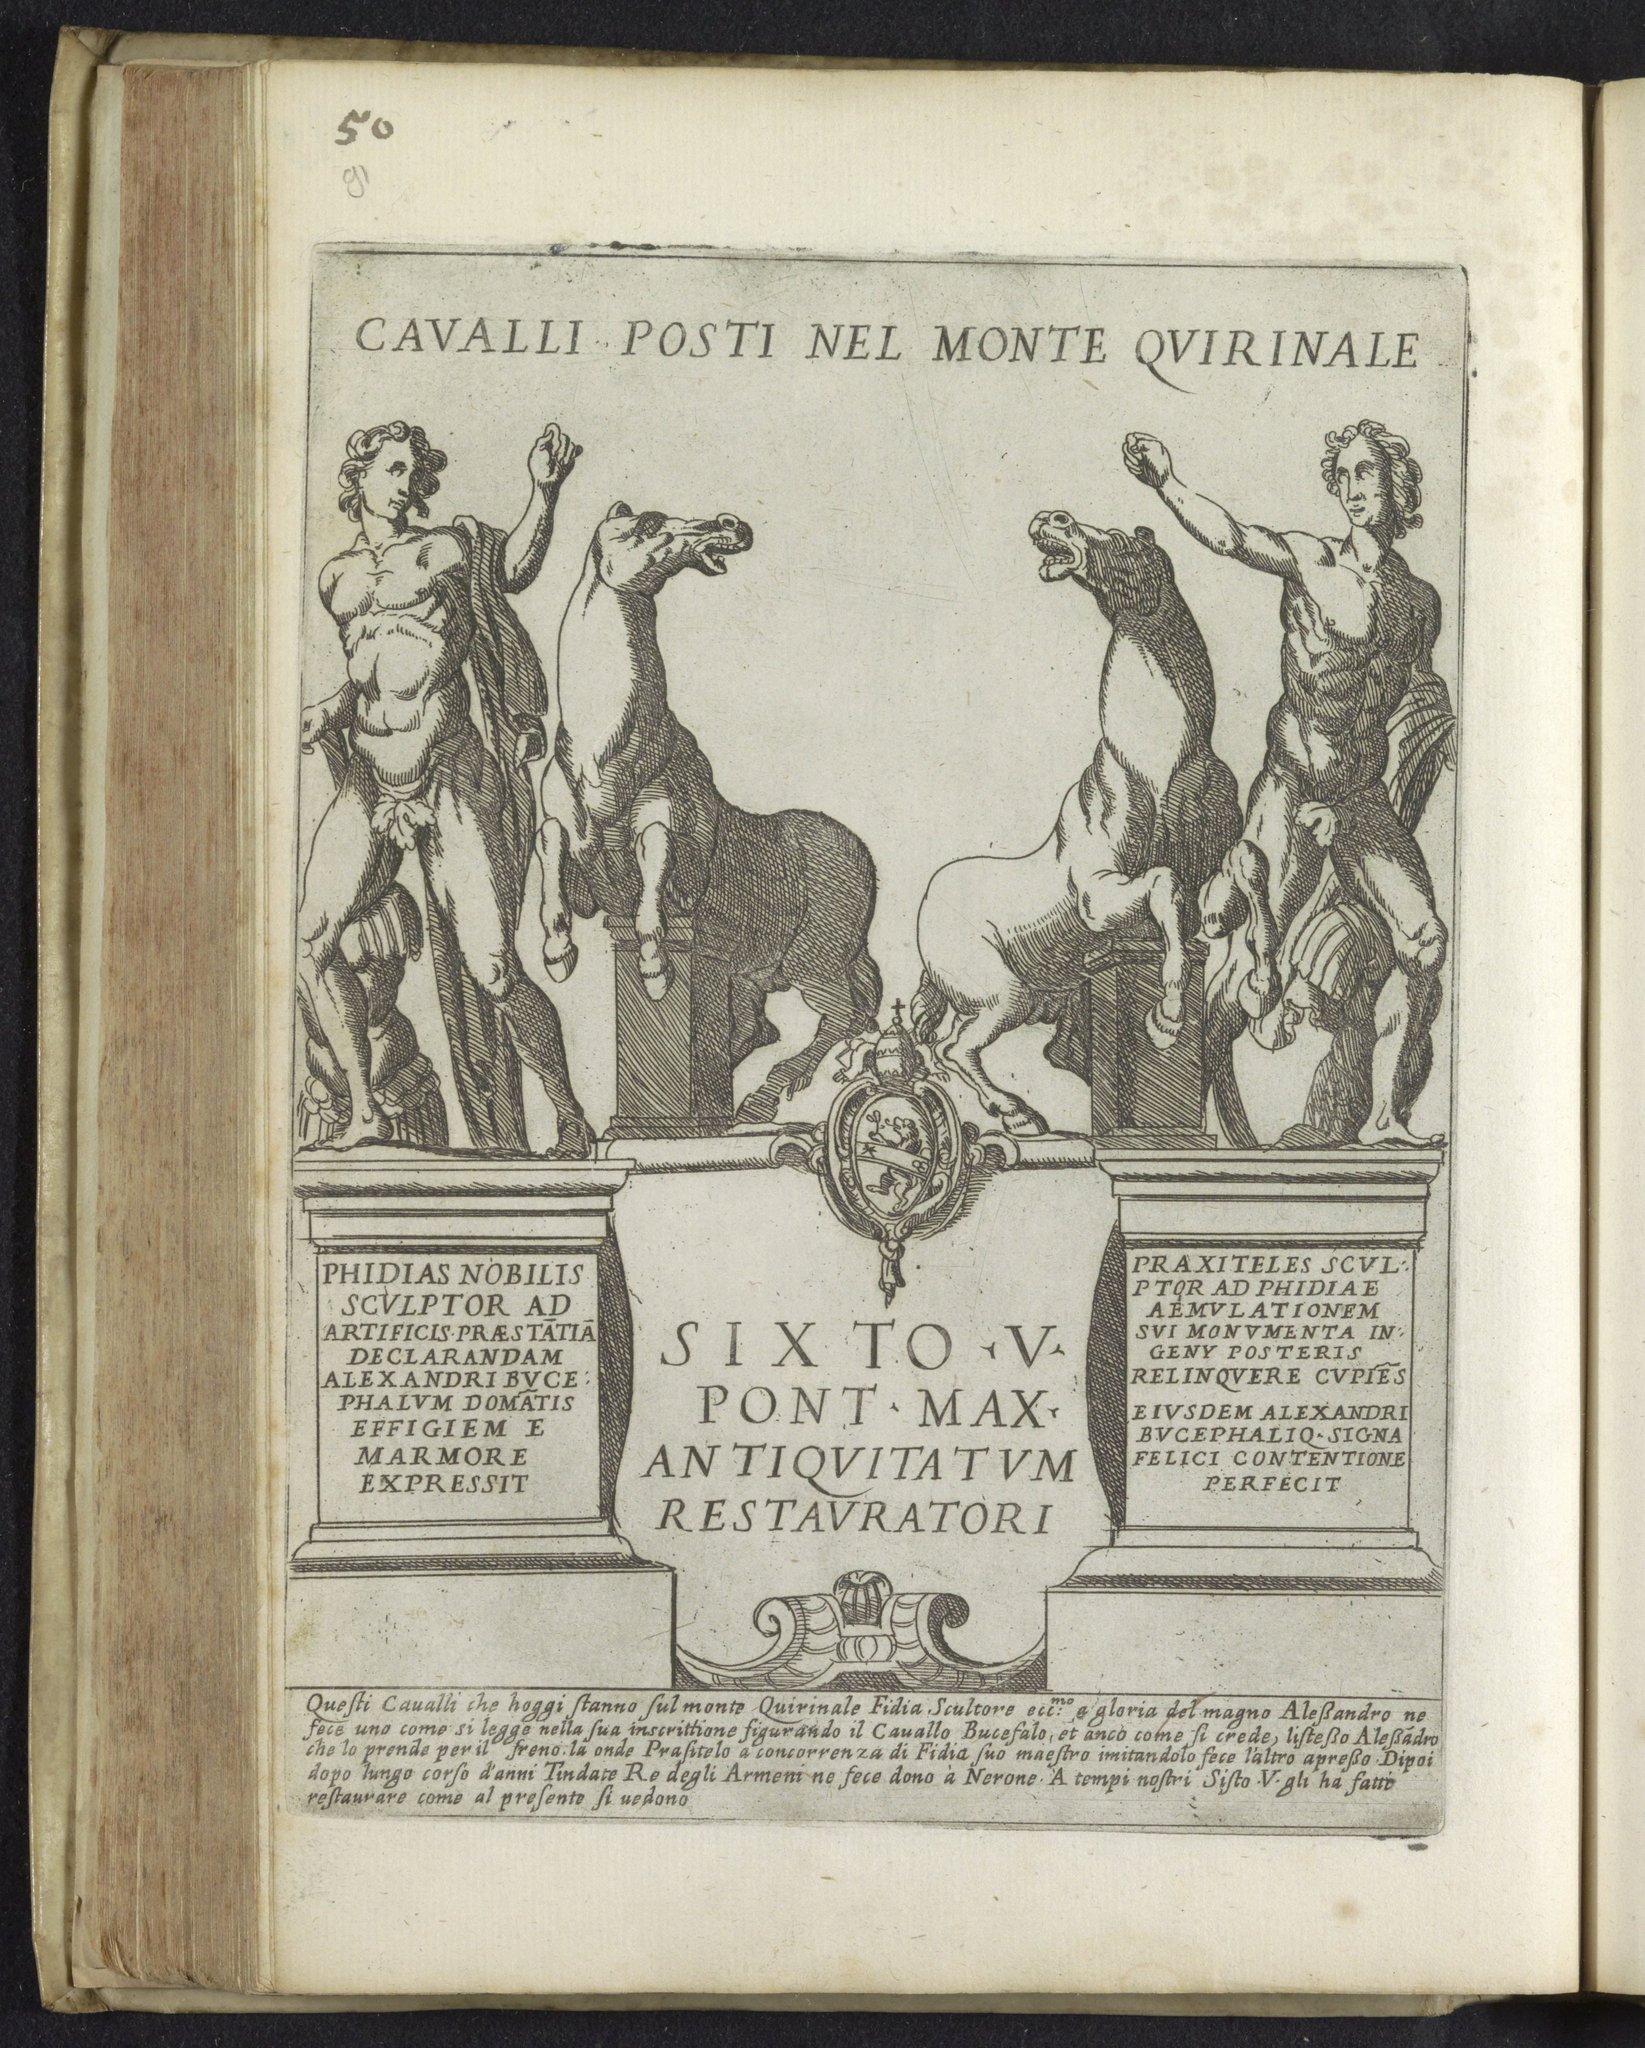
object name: album leaf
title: Moderne en antieke monumenten en bouwwerken in Rome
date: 1576-1618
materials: paper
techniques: etching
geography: rome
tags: piece of sculpture, reproduction of a piece of sculpture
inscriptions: number: ‘50’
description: Twee standbeelden van de Dioscuren (Castor en Pollux), twee naakte mannen met paarden, van achteren gezien. Voorheen geïnterpreteerd als de kunstenaars Pheidias en Praxiteles. De beelden staan op het Piazza del Quirinale in Rome. Tekst in het Italiaans in de ondermarge. De prent maakt deel uit van een album.